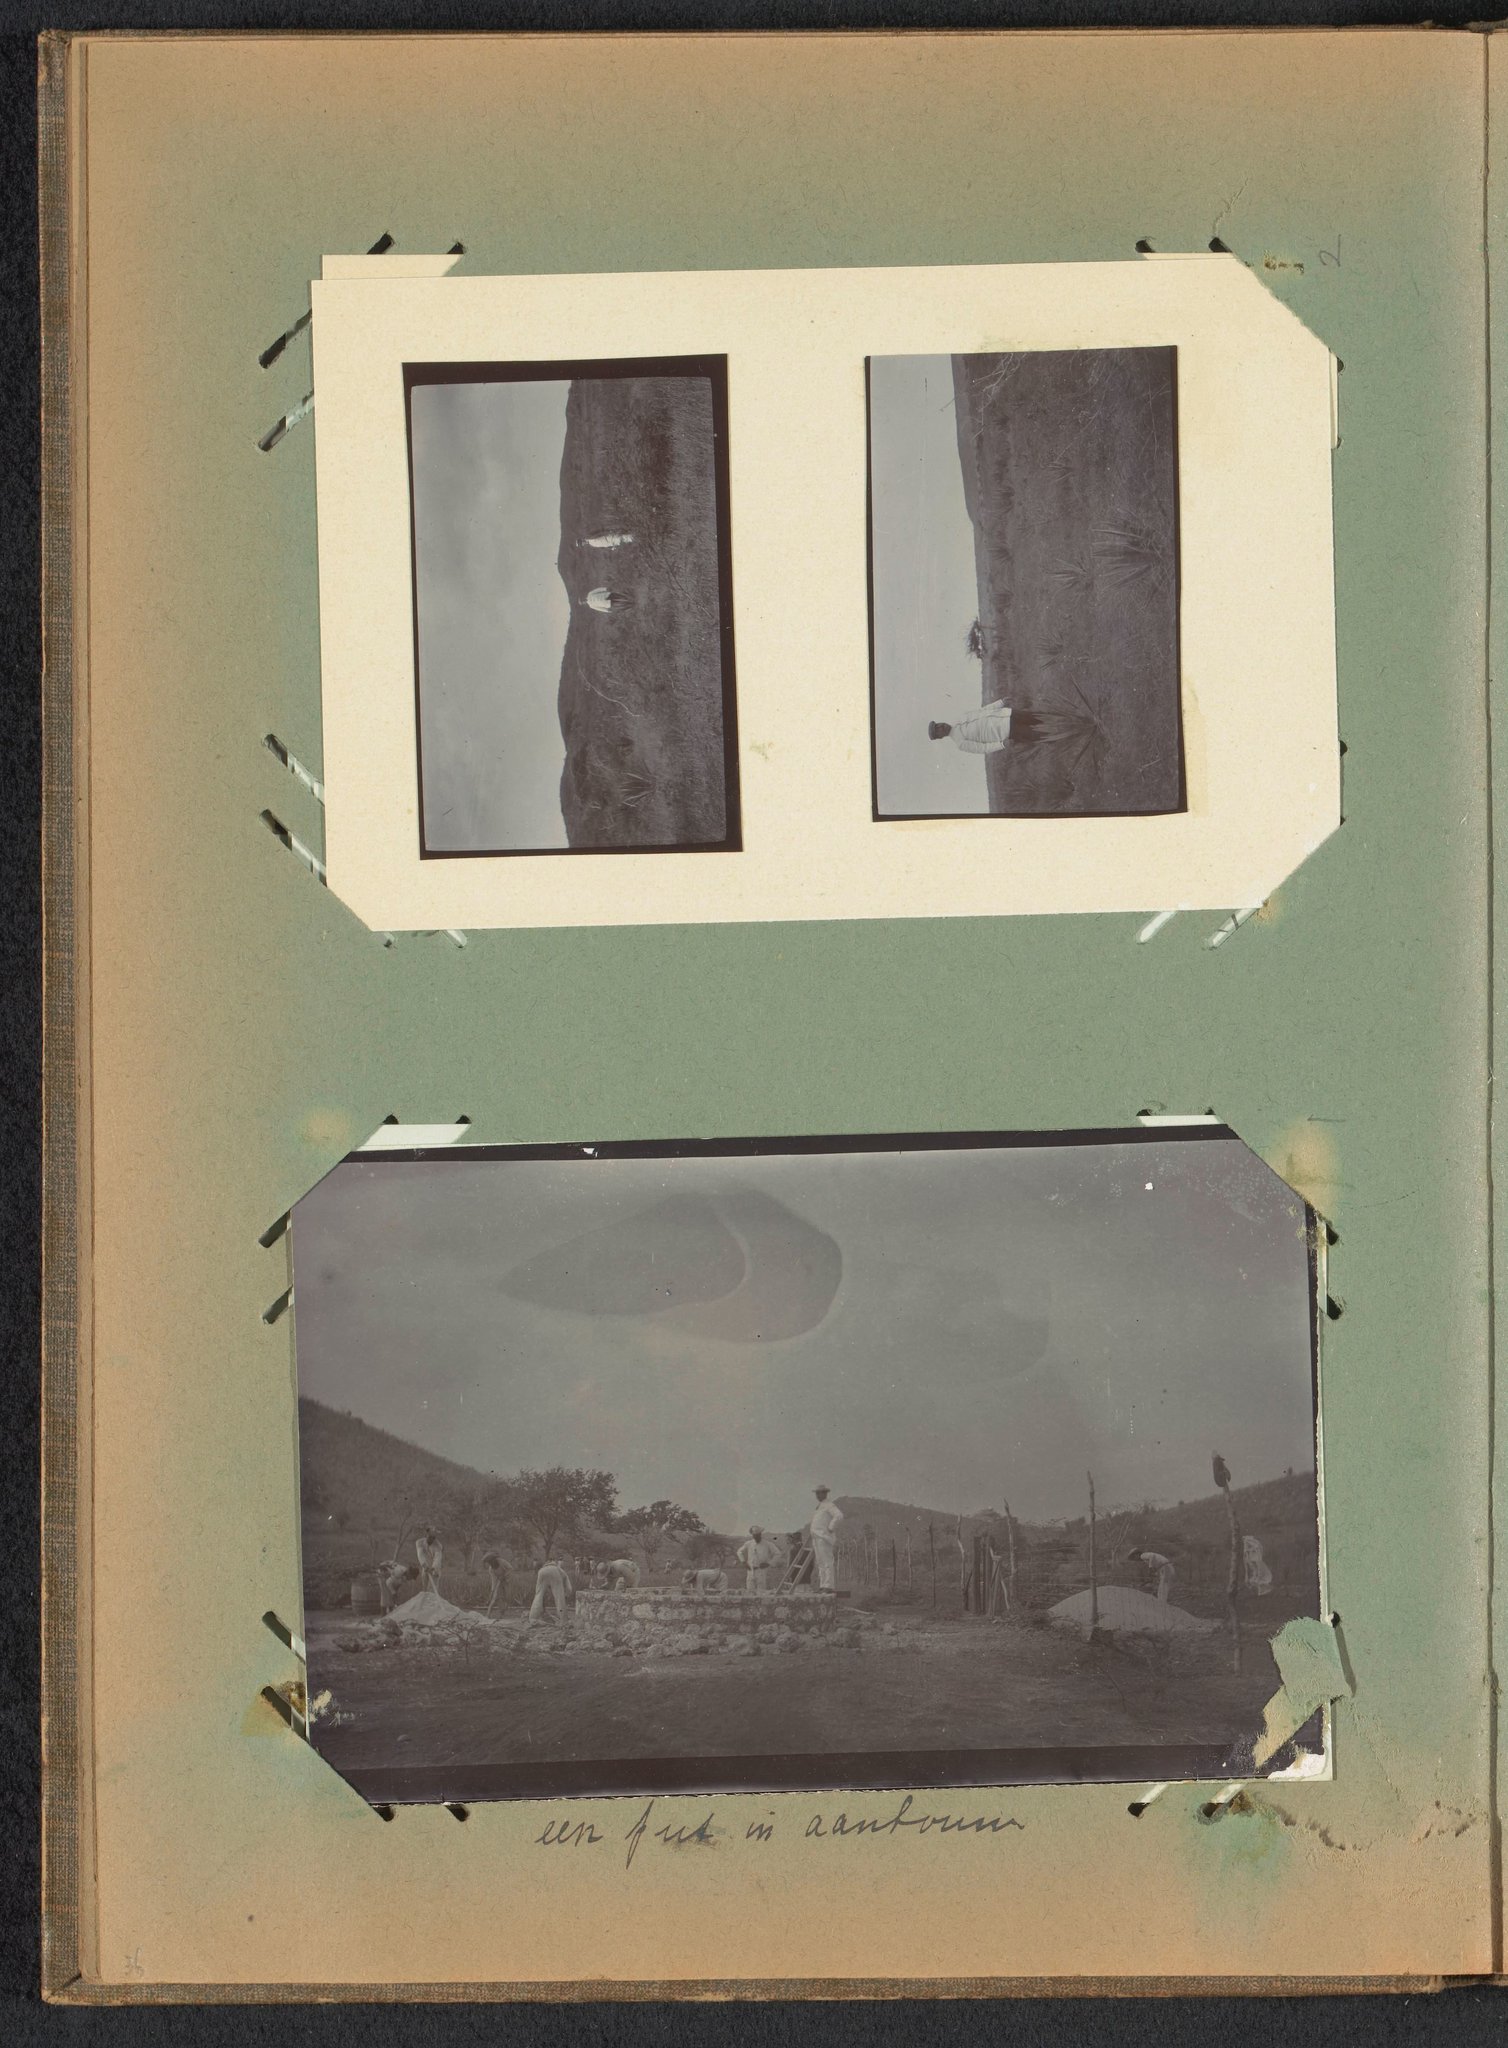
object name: photograph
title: Put in aanbouw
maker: Anonymous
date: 1912-1913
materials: paper, photographic support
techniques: gelatin silver print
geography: curacao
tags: plantation, well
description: Werkzaamheden bij een put in aanbouw. Bij Plantage Mount Pleasant op Curaçao. Onderdeel van het fotoalbum uit ca. 1912-1913 met 92 foto's van de plantages Peperpot en Dordrecht in Suriname en Mount Pleasant op Curaçao.